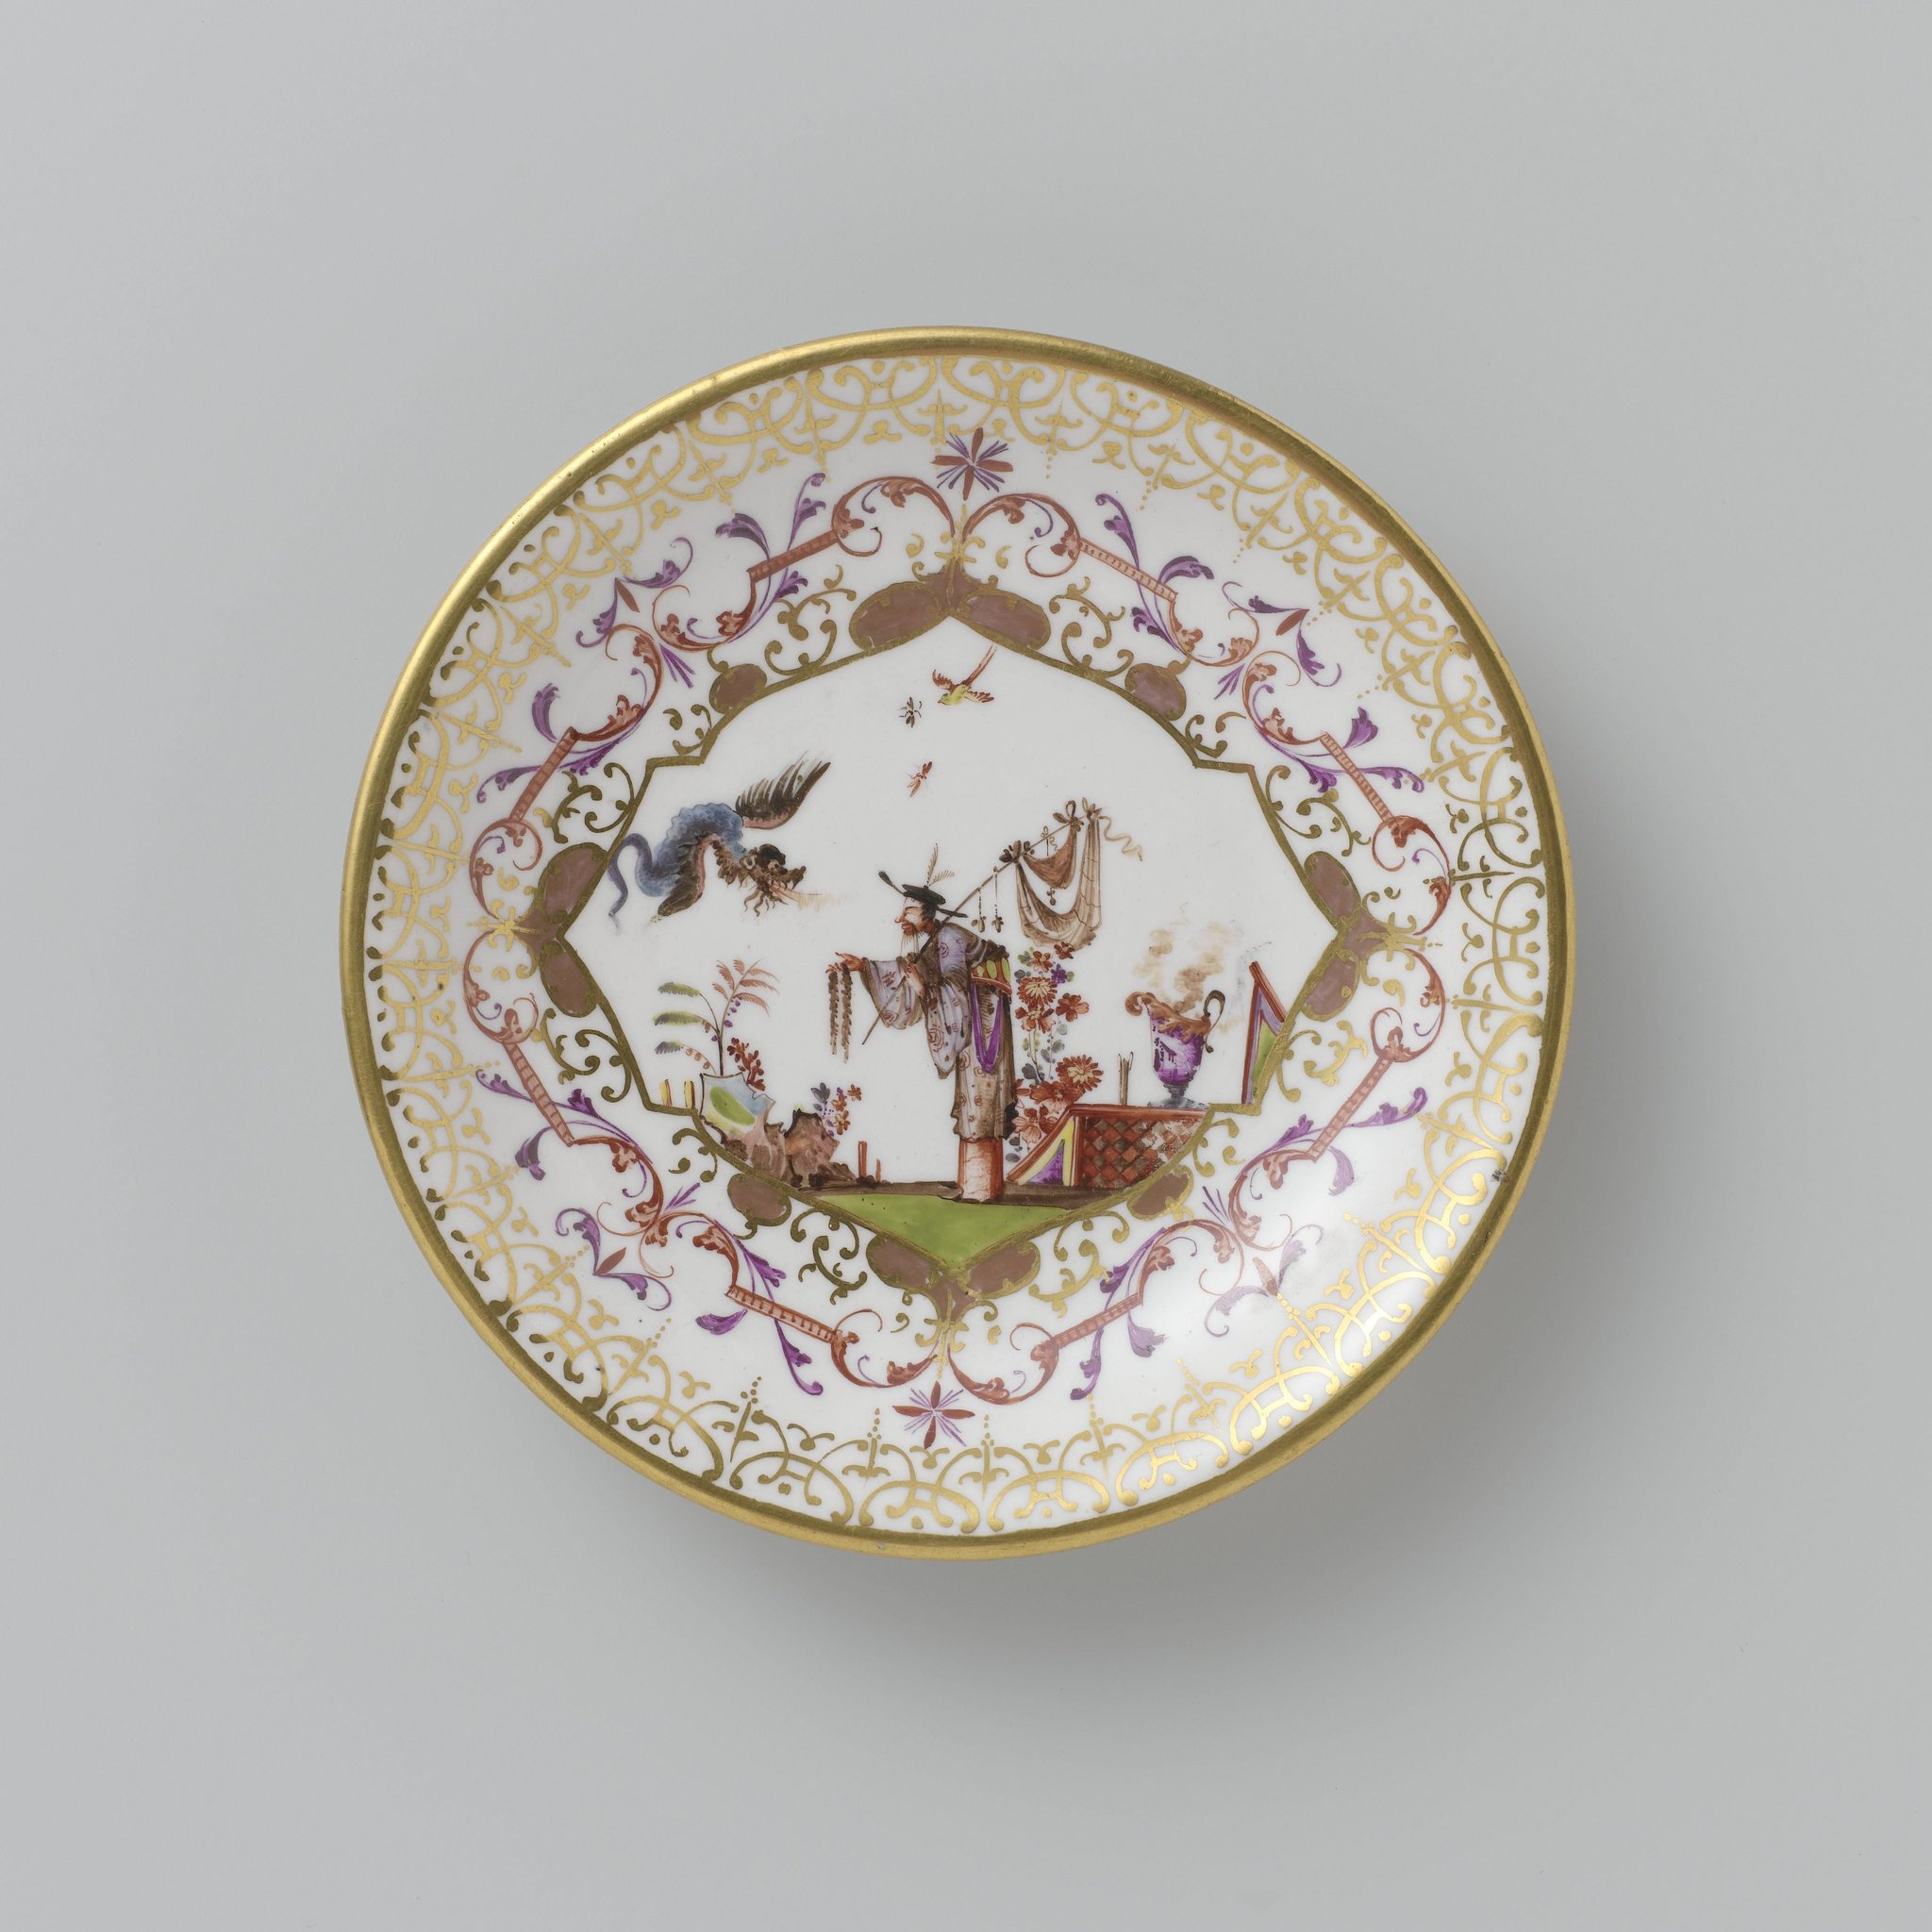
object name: platter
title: Chocolate cup and saucer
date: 1725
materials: porcelain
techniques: painted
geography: meissen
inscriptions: label: ‘SAMMLUNG / Dr. FRANZ OPPENHEIMER’, number: ‘134.’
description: Meissener Porzellan Manufaktur Meissen, c. 1725 hard-paste porcelain